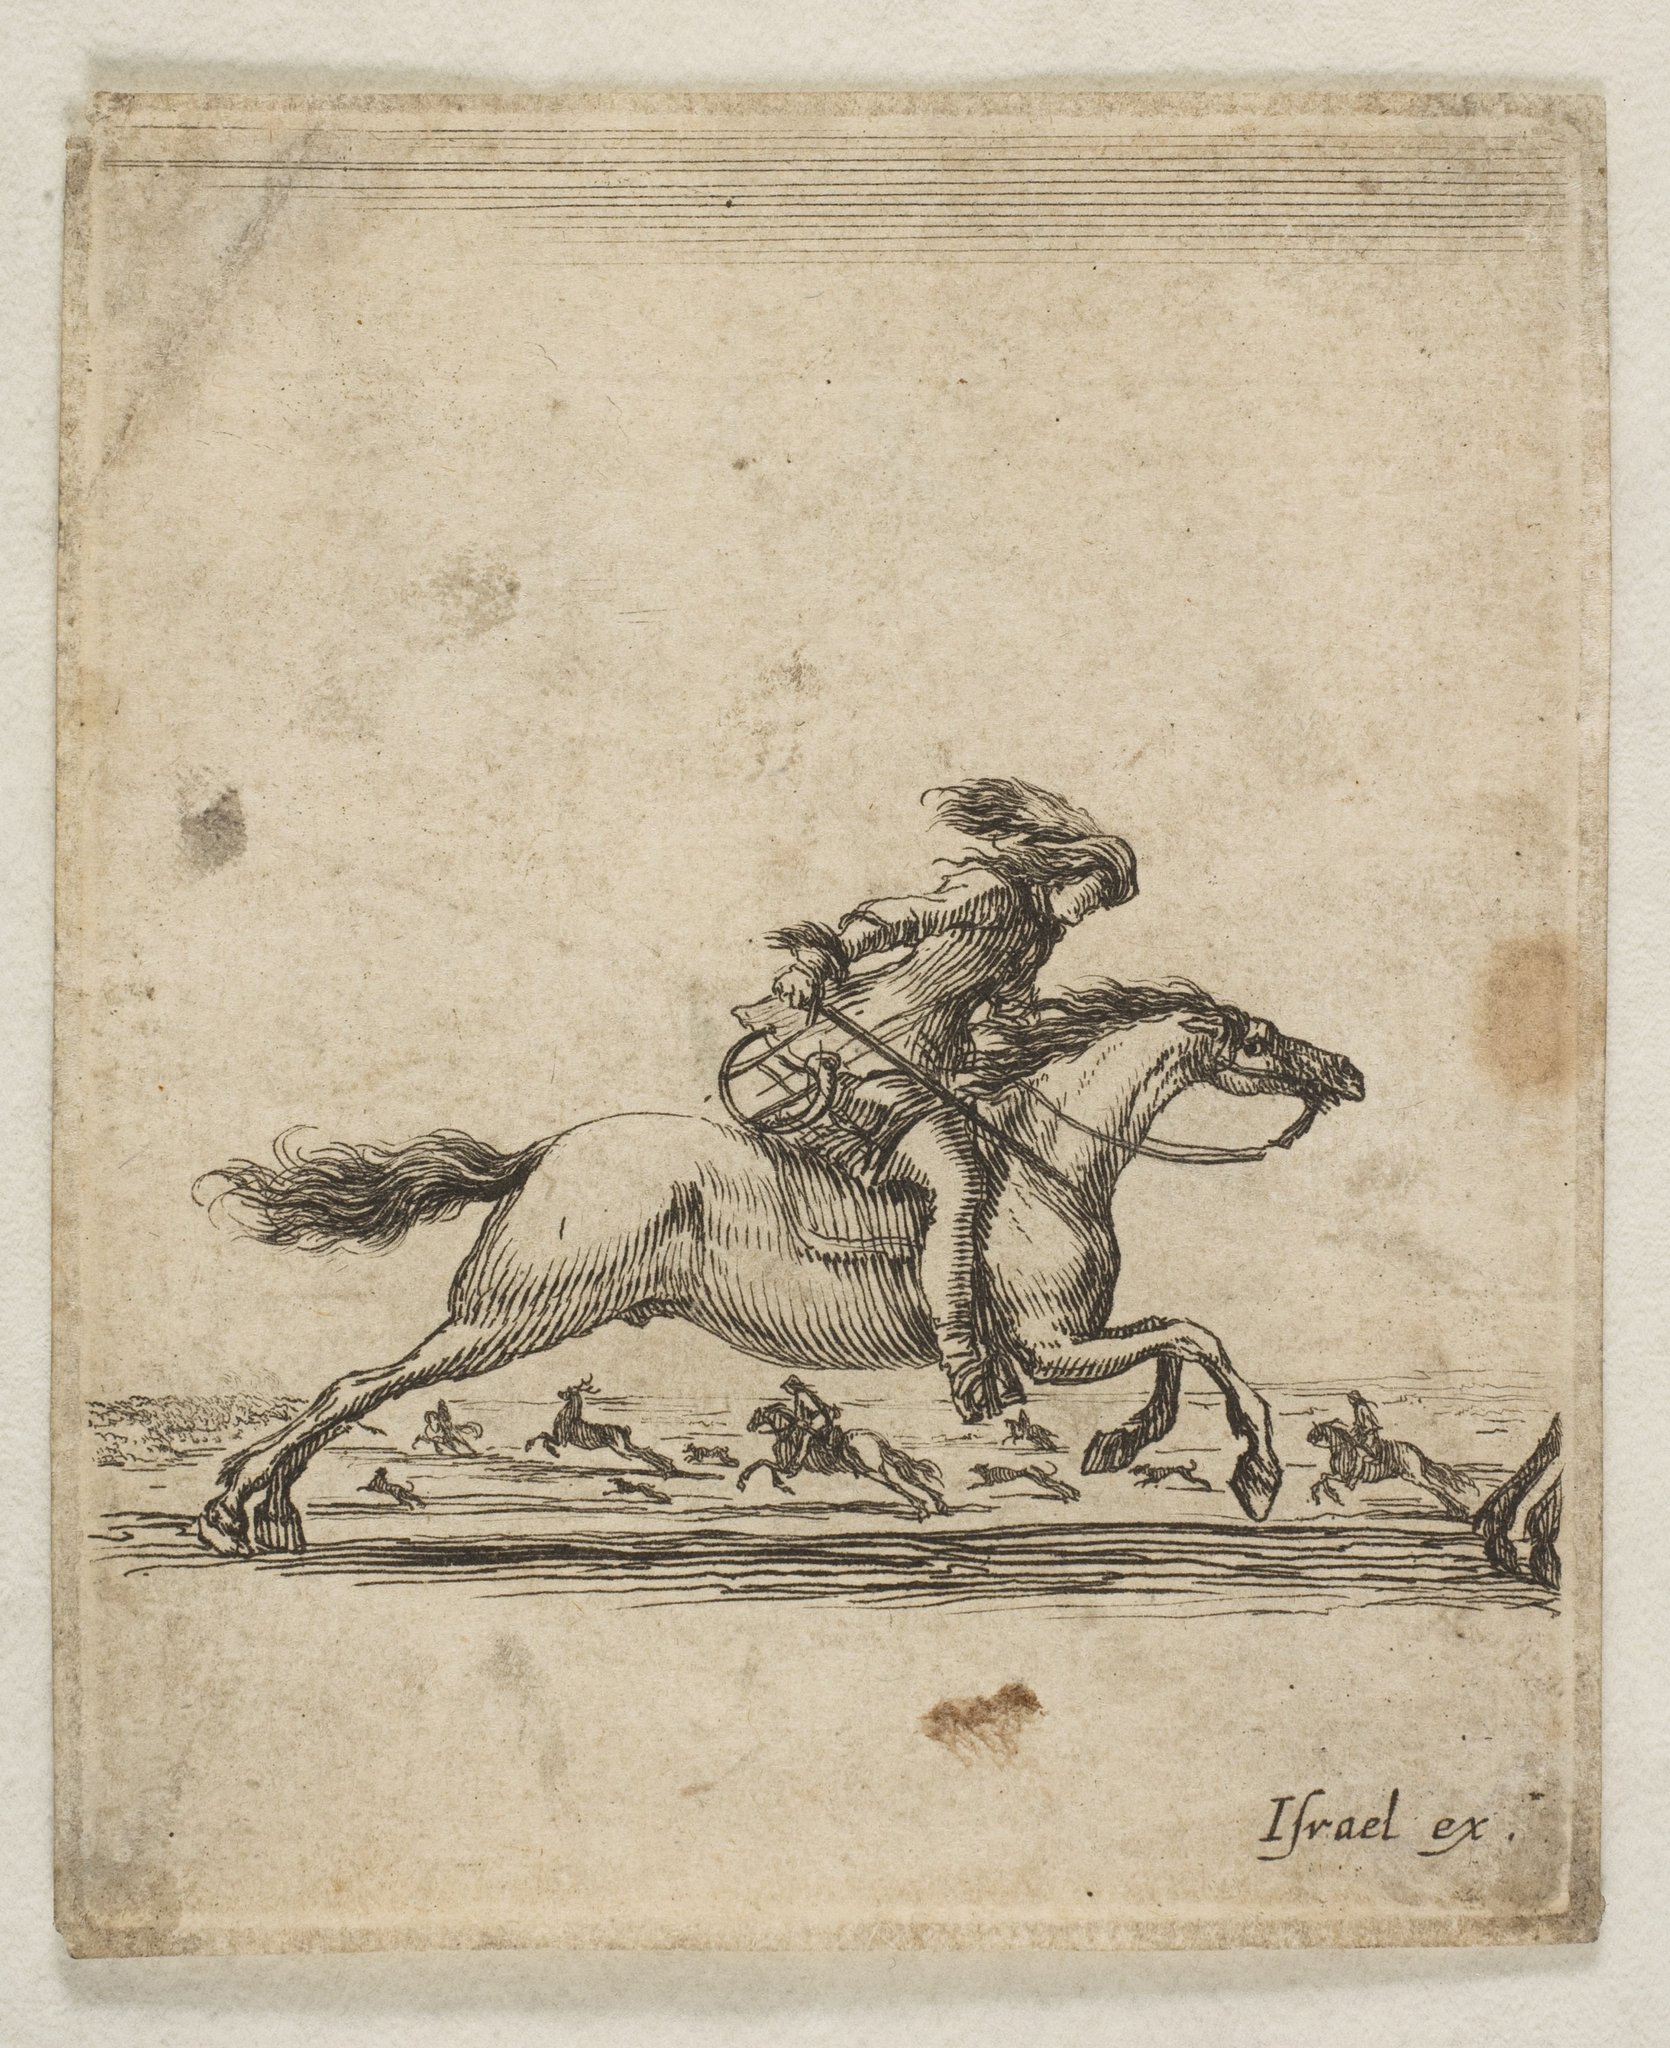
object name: print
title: A horseman with sword in hand galloping towards the right, other horsemen galloping towards the left in the background, from "Various cavalry exercises" (Diverses exercices de cavalerie)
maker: stefano della bella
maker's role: artist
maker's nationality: italian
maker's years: 1610-1664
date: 1645-1646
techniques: etching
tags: swords,men,horses